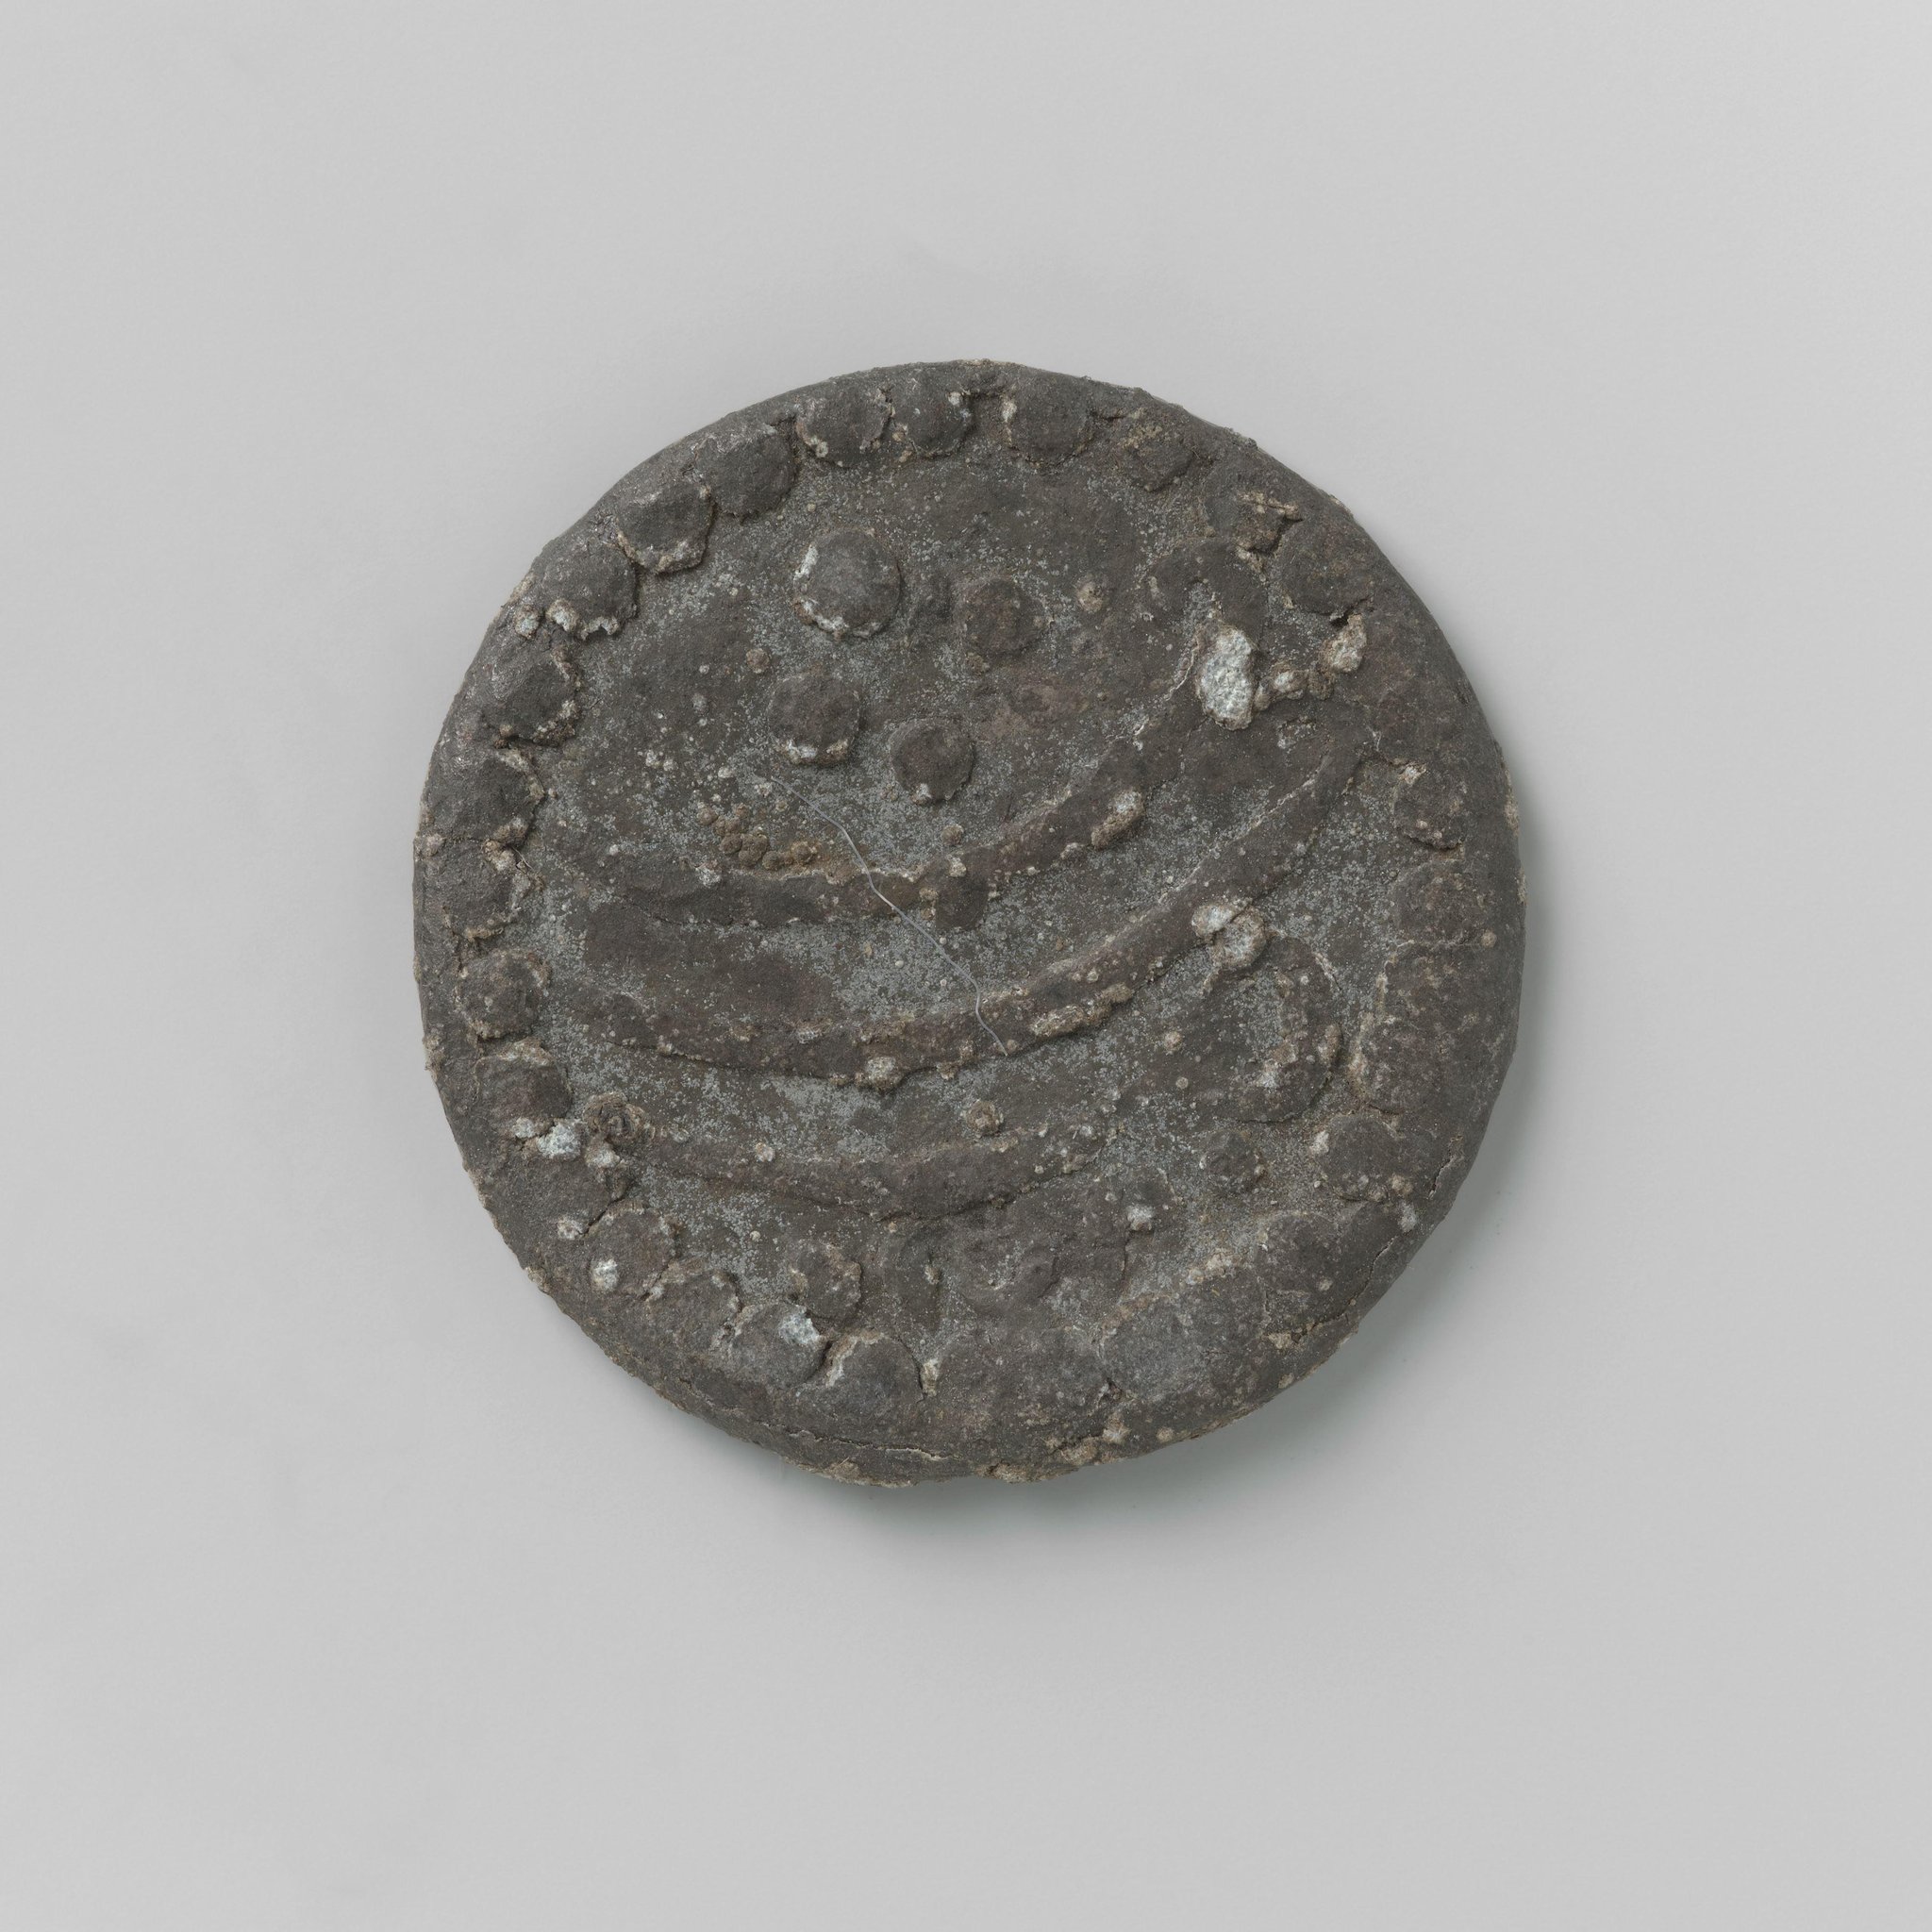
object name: coin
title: Atjeh, Sumatra, sultan Ala ed-din Mansoer II, kasja, AH 1260 (1844)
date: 1854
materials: tin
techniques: casting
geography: aceh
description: Tinnen munt. Voorzijde: drieregelig opschrift in Arabische lettertekens. Keerzijde: drieregelig opschrift in Arabische lettertekens, waaronder jaartal in Islamitische jaartelling